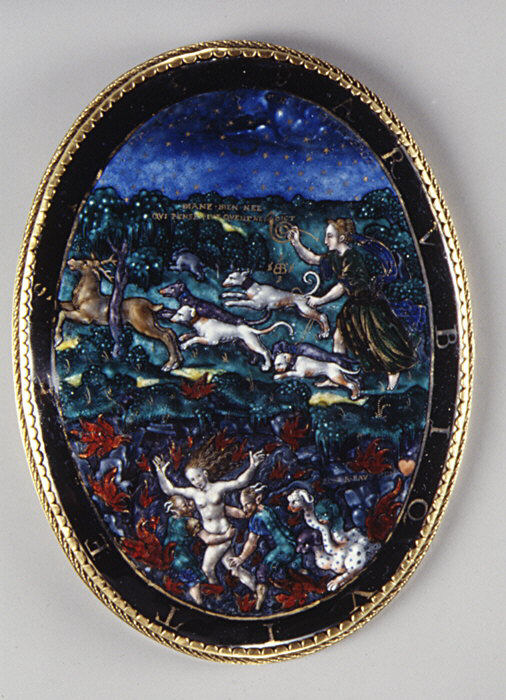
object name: plaque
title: Diana Hunting and Proserpina in the Underworld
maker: master i. d. c.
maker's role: enameler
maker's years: 1550-1599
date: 1601-1633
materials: copper, enamel, gilt, metal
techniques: gilding, painting, silvered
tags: female nudes,hunting,horns,diana,deer,dogs,fire,night,persephone,hades